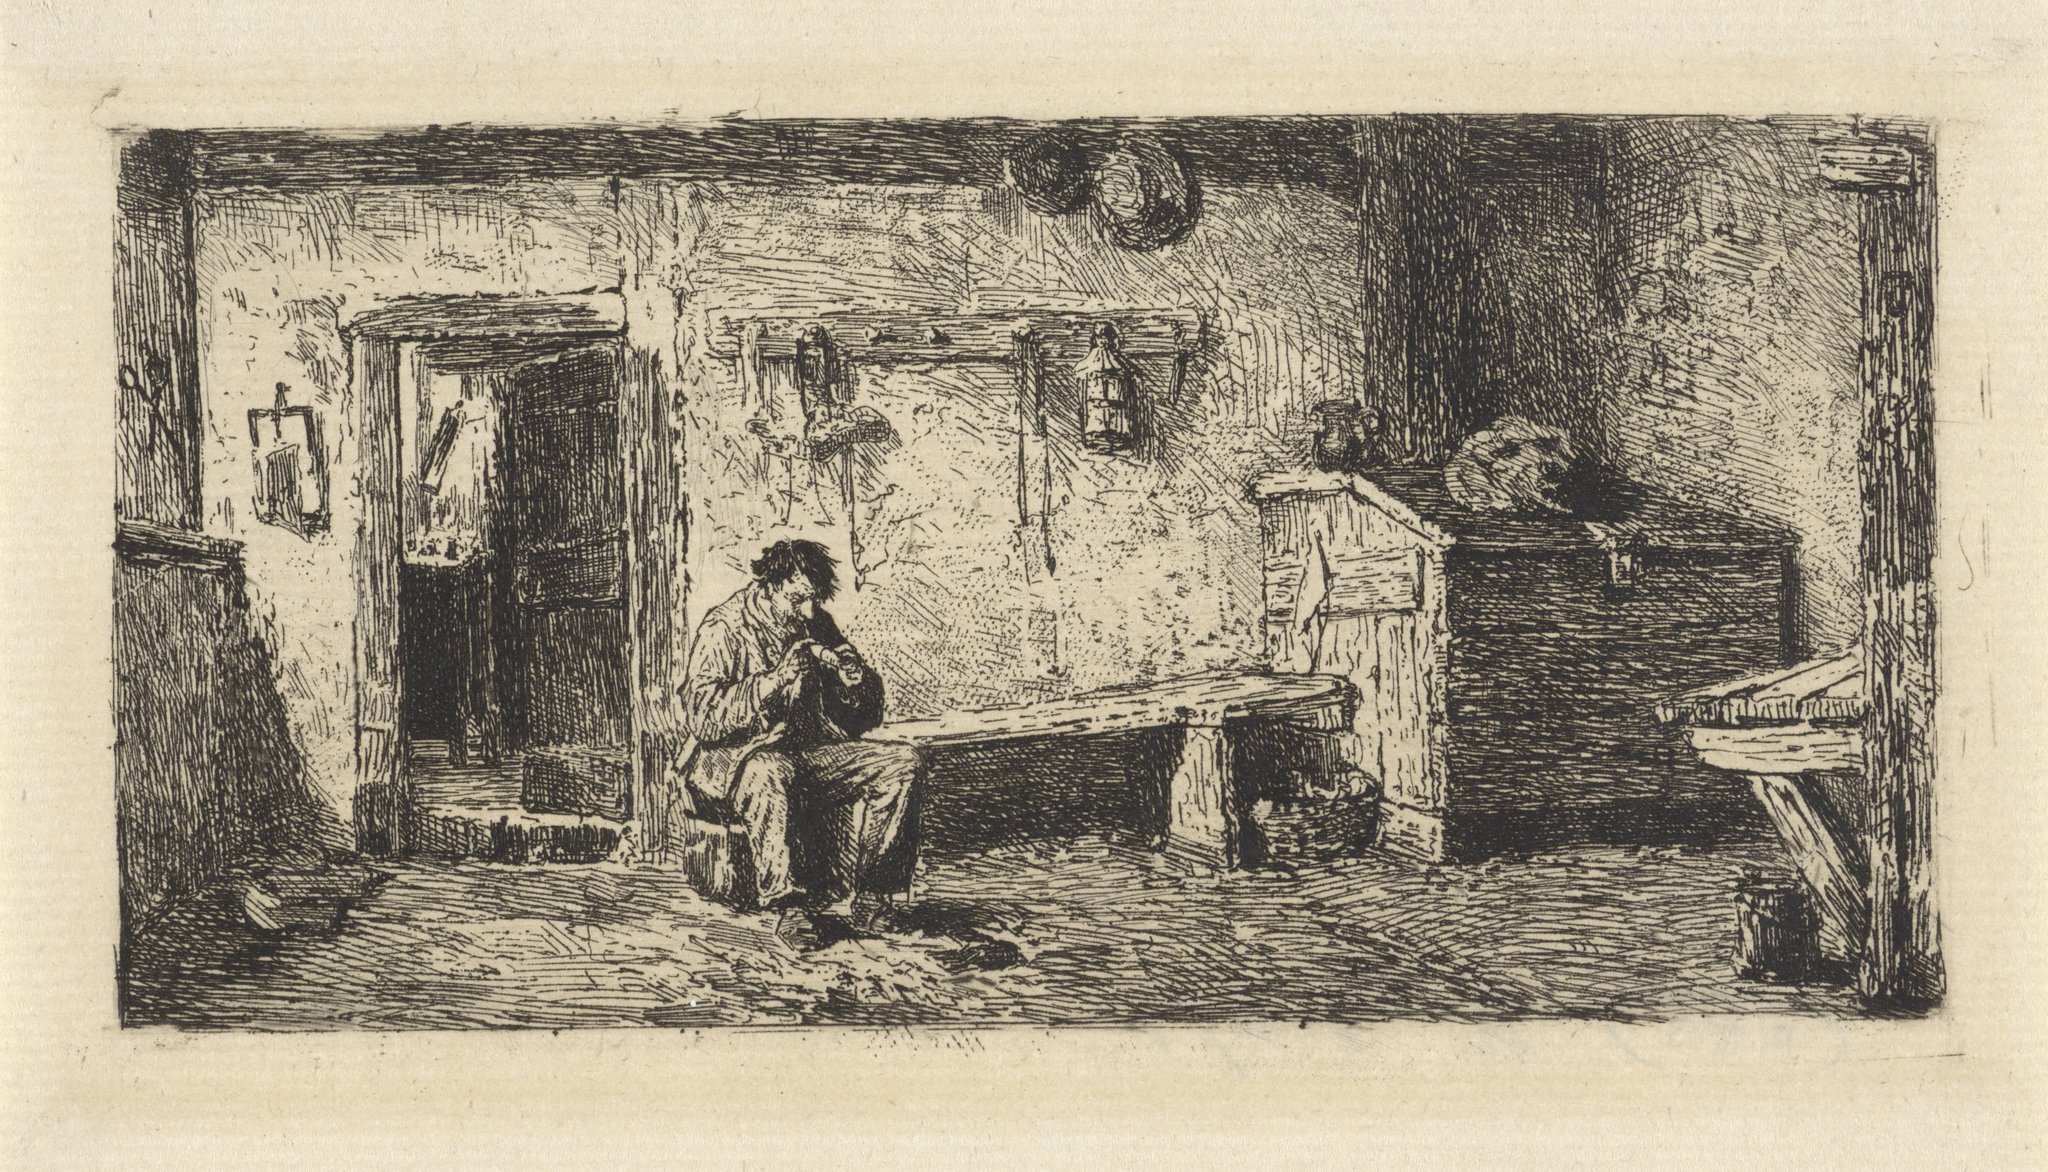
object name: print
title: Pijprokende man in een schuur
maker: hendrik jacobus scholten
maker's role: draughtsman, painter, print maker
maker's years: 1824-1907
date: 1836-1886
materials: paper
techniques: etching, roulette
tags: pipe ~ tobacco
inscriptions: collector's mark: Lugt 2228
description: In een armoedig vertrek of schuur steekt een man op een bankje aan een tondel zijn pijp aan. Rechts staat een grote kist waarop een waterkan. Aan de muur een kapstok waaraan een lantaarn en touw hangen.